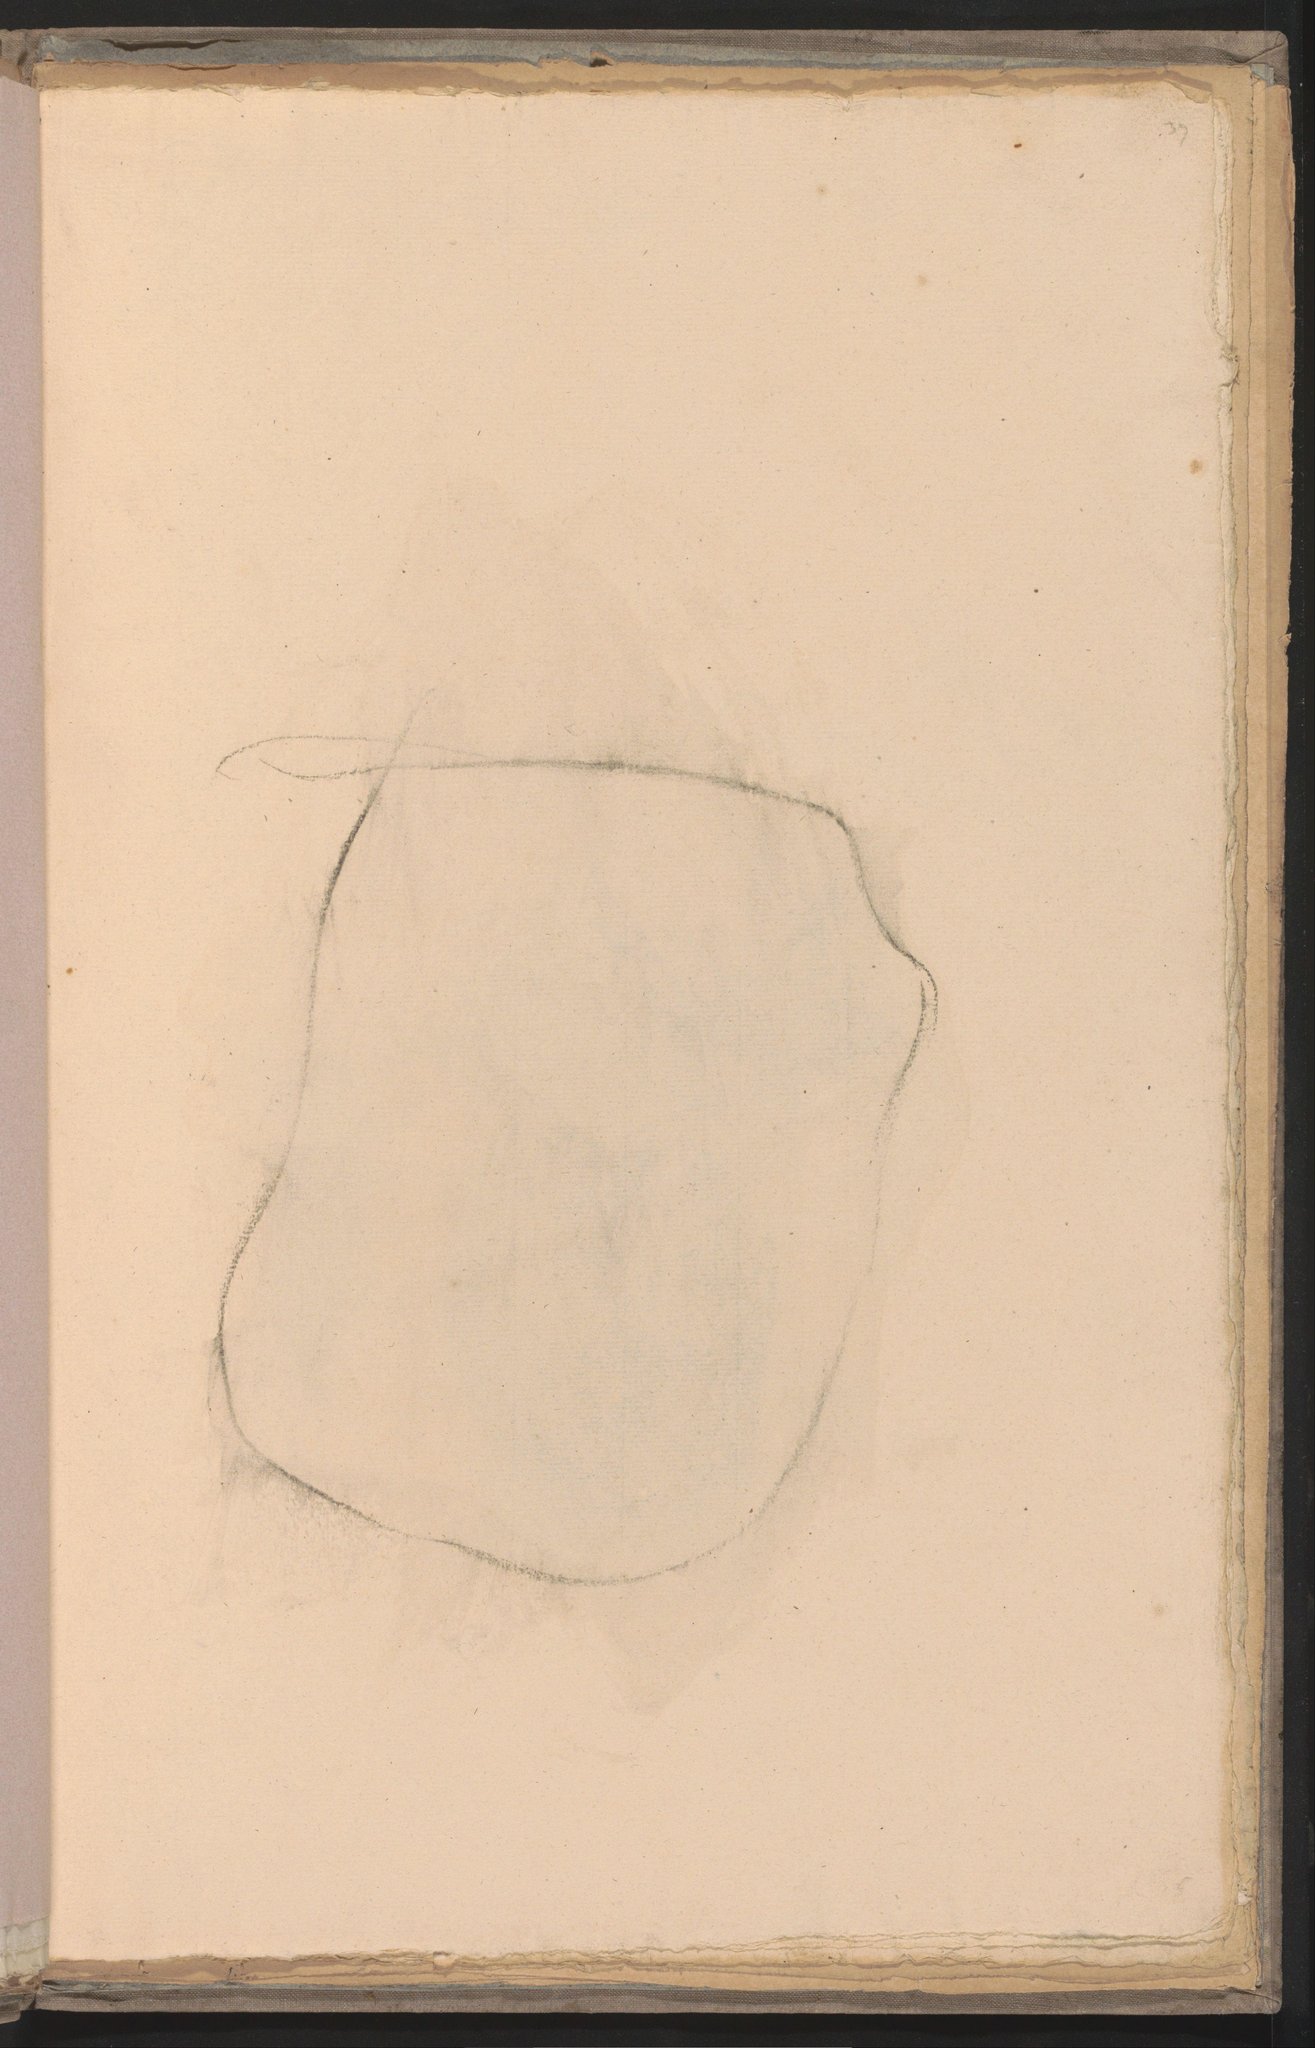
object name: sketchbook leaf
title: Studie, mogelijk de omtrek van een gezicht in profiel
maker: willem witsen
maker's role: draughtsman, painter, print maker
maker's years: 1860-1923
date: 1886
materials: chalk, paper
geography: ewijkshoeve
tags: face (+ sideview, profile)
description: Pagina 37 uit een schetsboek met 38 bladen betekend rond de Ewijkshoeve.